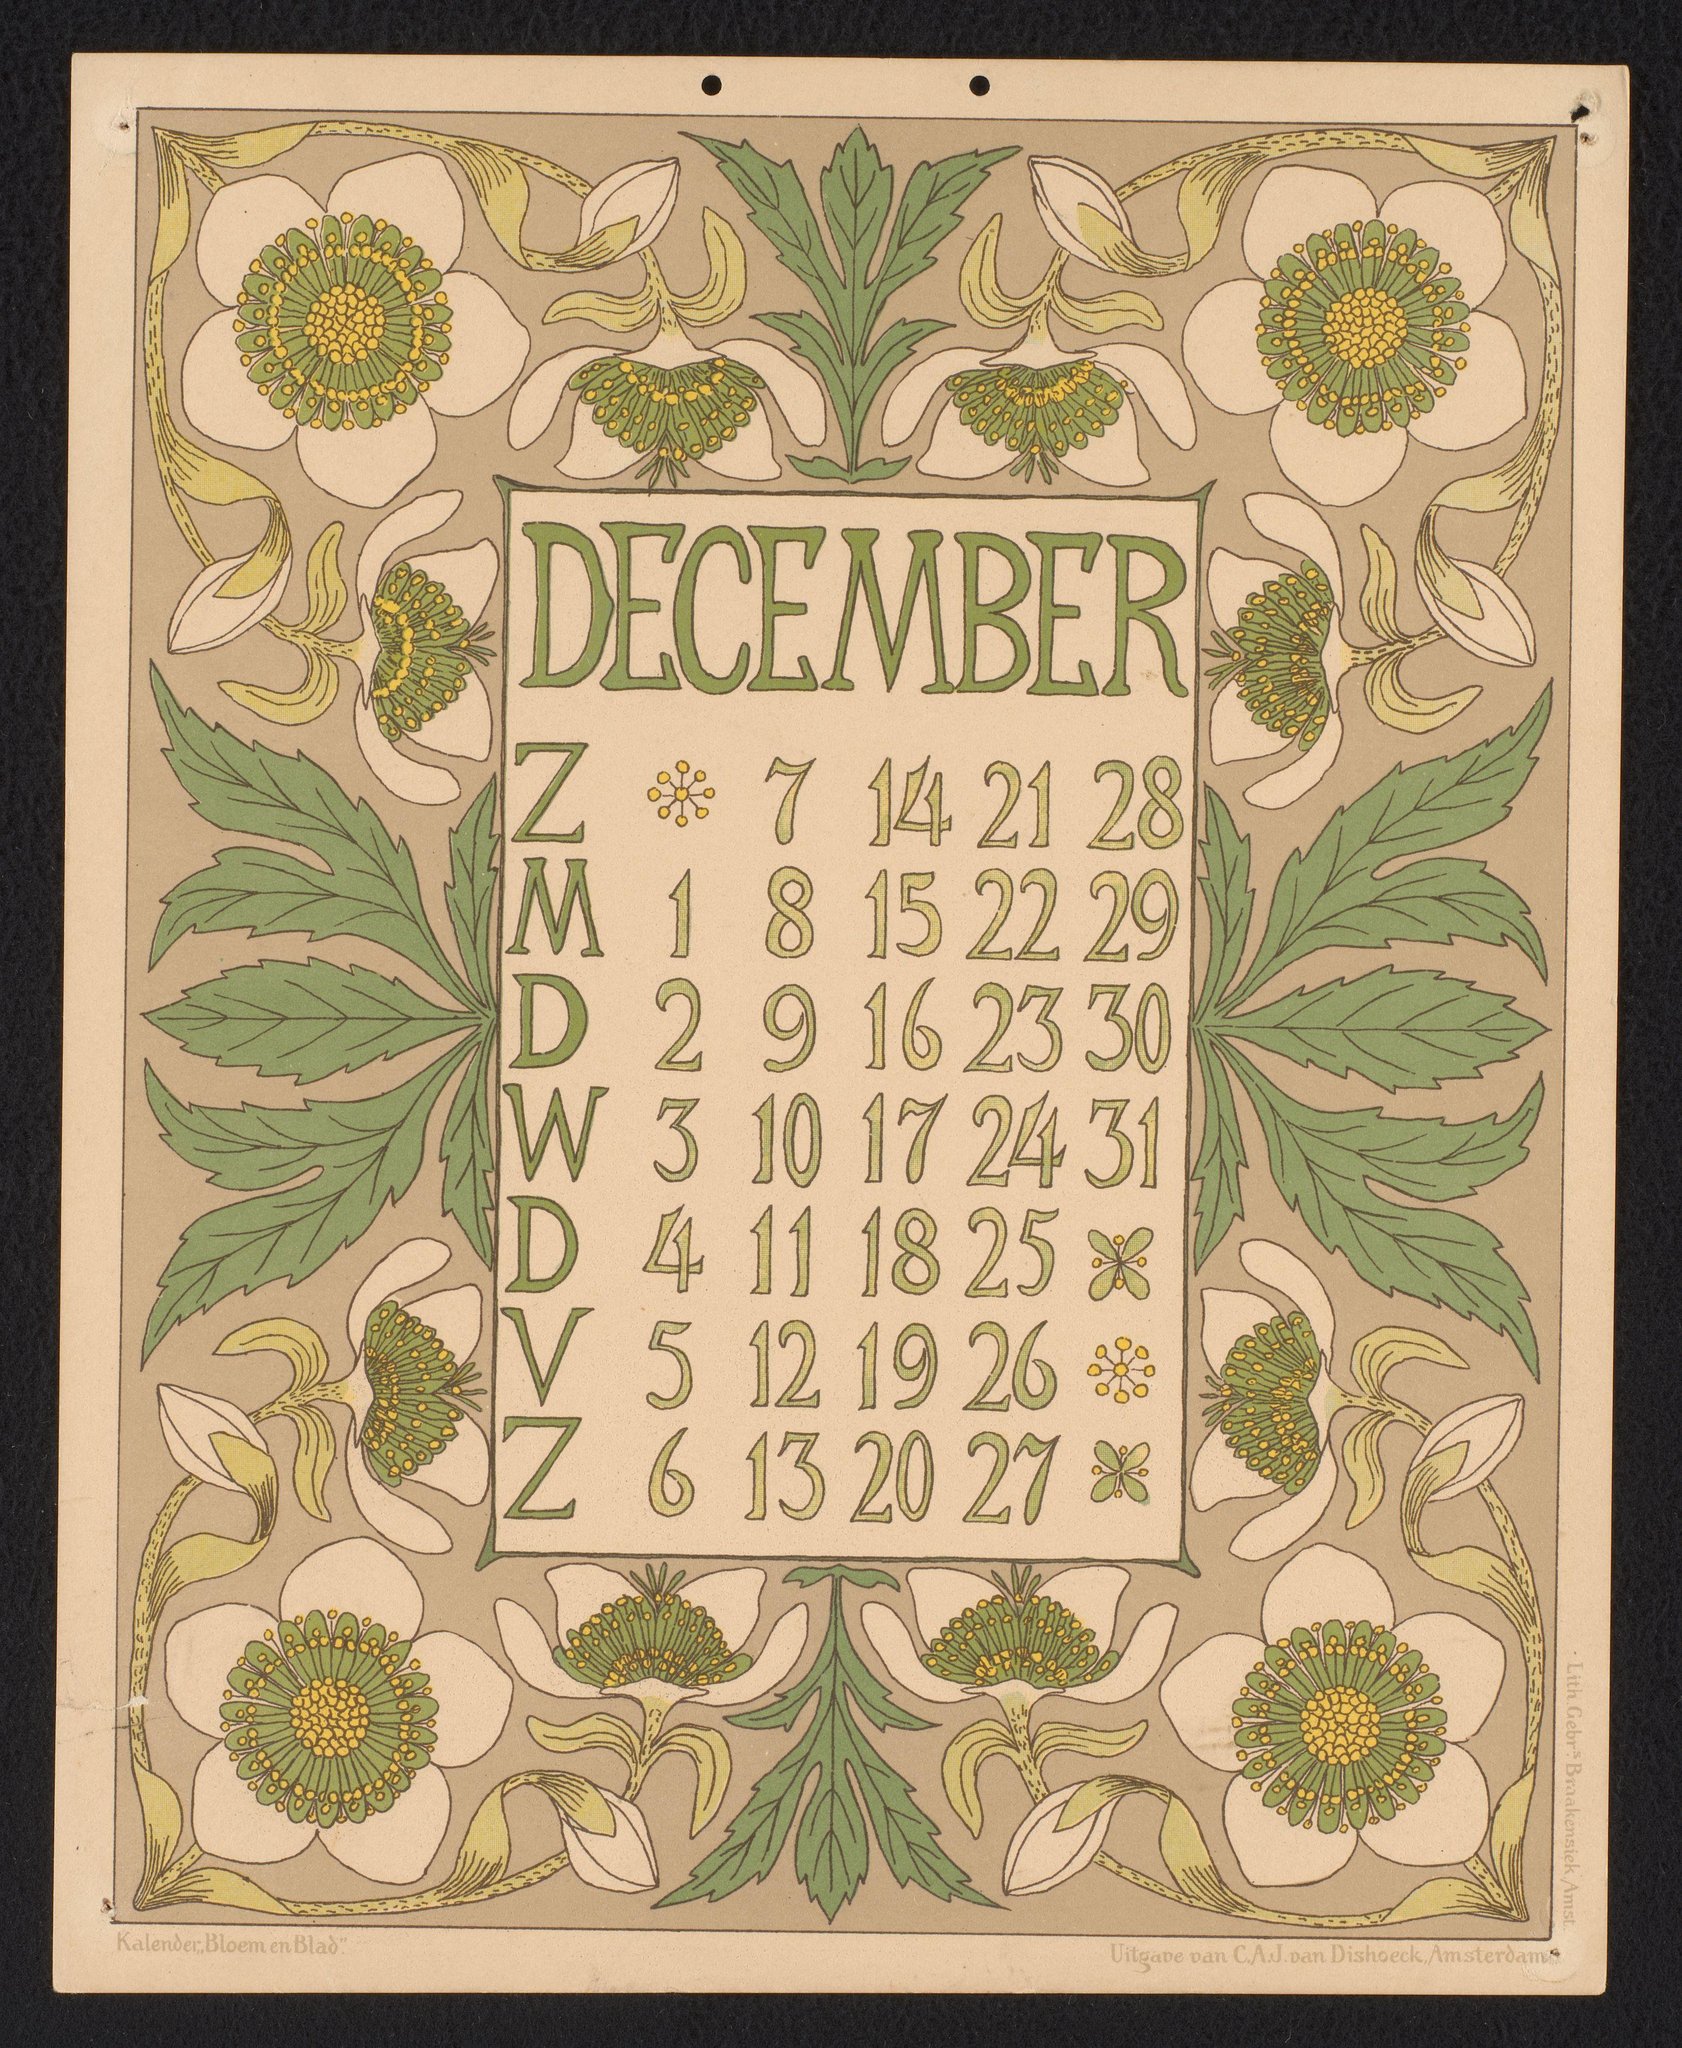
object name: calendar leaf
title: Kalenderblad voor december 1902 met kerstroos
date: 1901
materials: paper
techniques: lithograph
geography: amsterdam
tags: flowers, calendar, almanac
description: Decoratieve rand met kerstroos rond de maandkalender voor december. Kalender 'Bloem en Blad'.